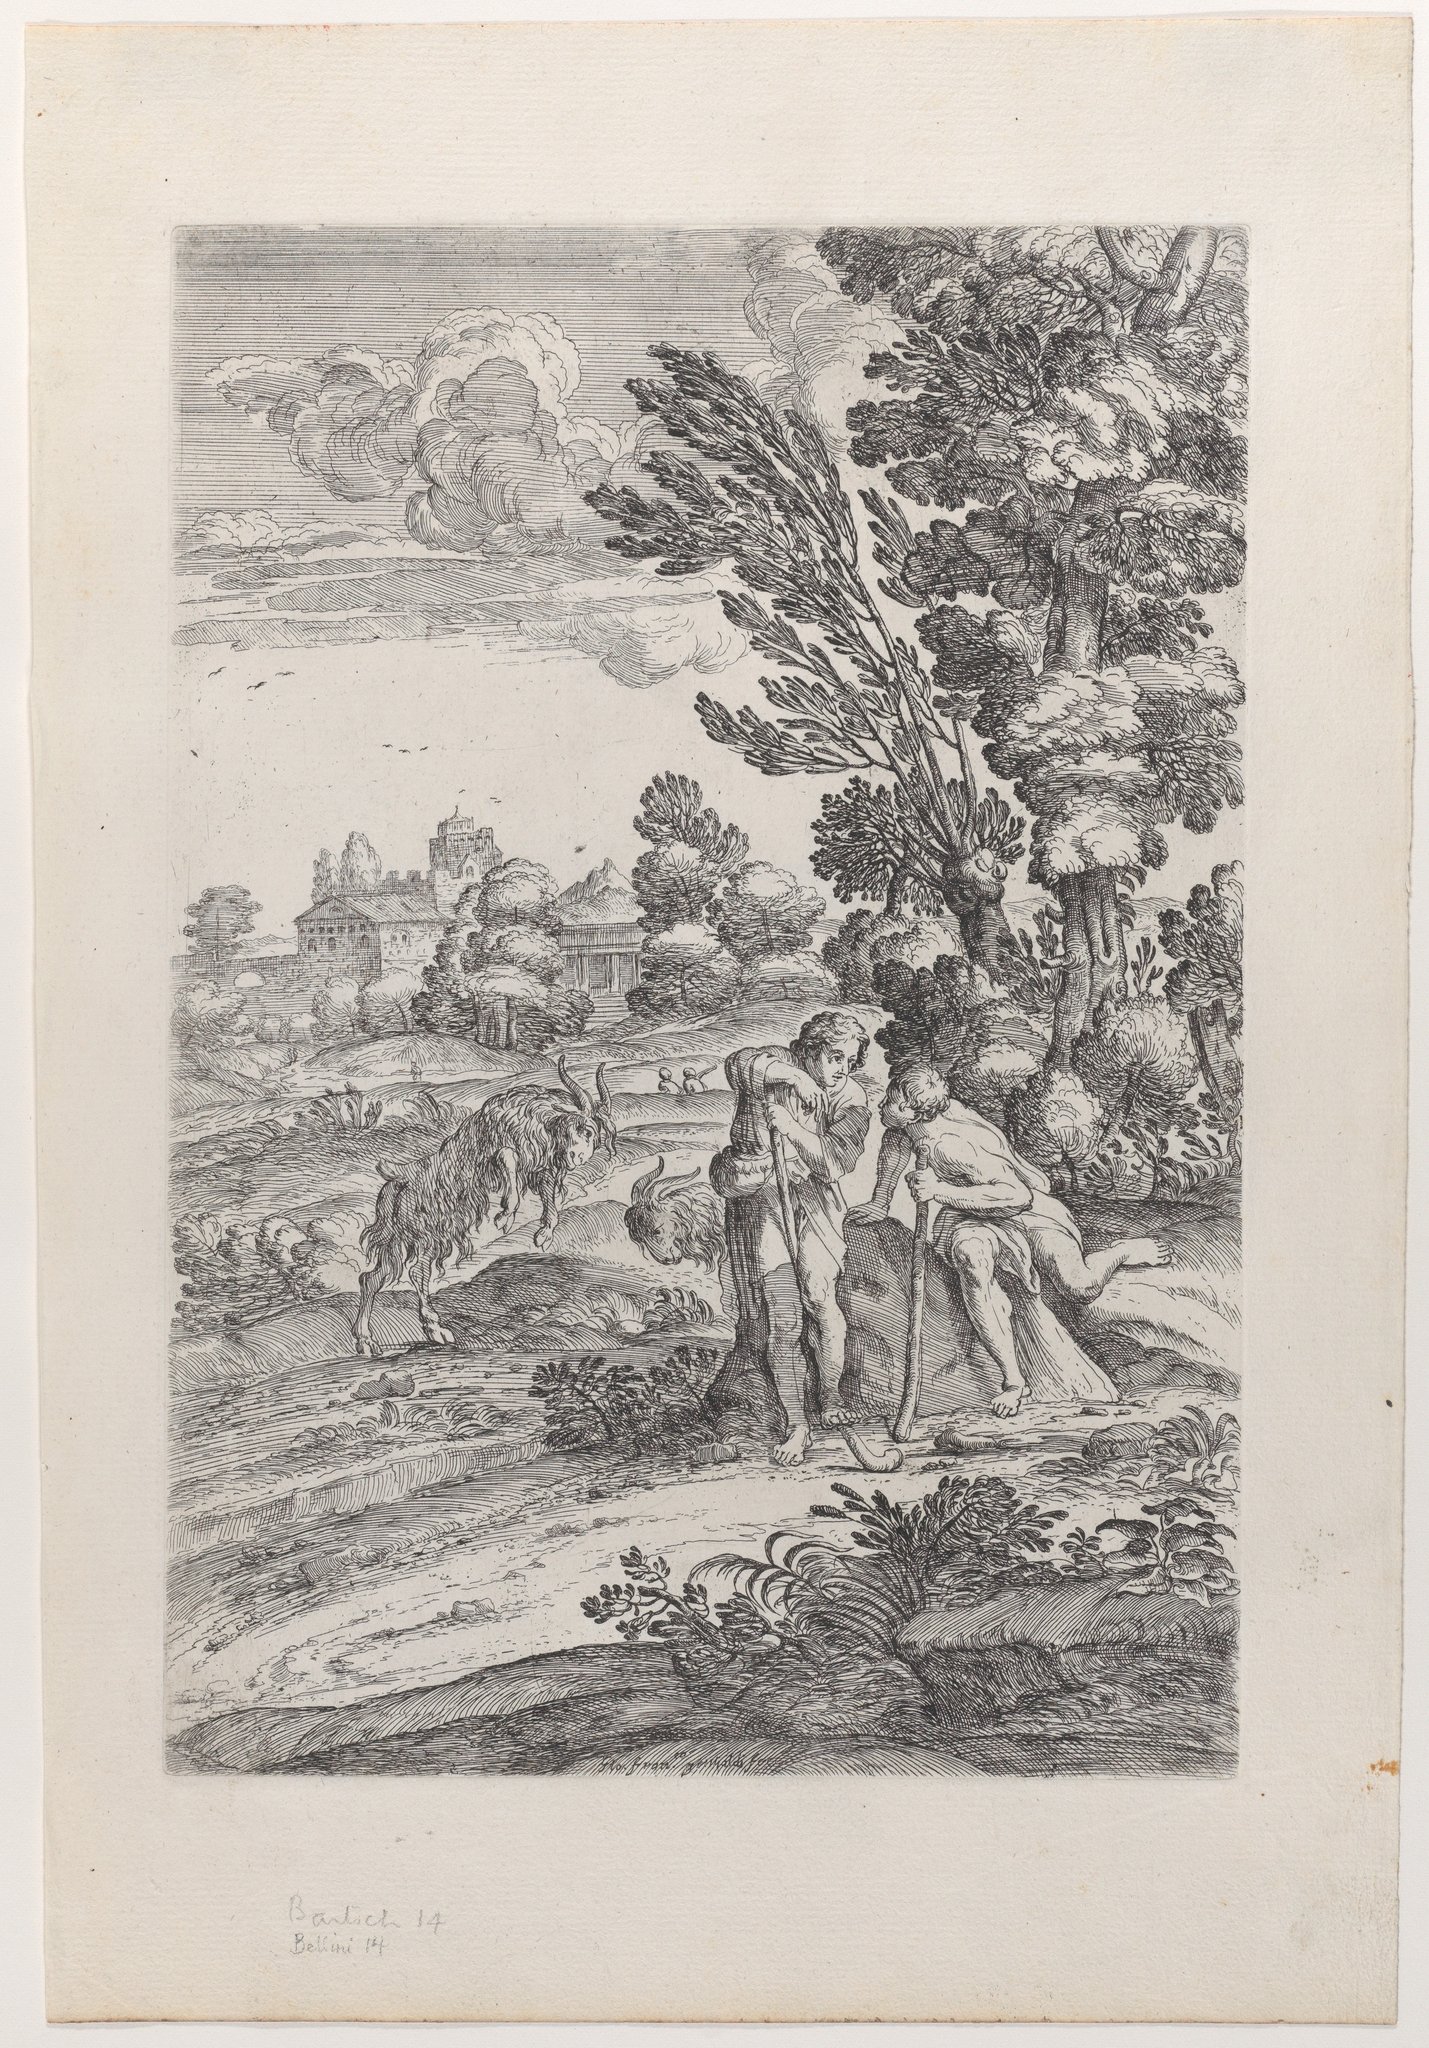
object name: print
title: Landscape With Two Goatherds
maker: giovanni francesco grimaldi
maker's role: artist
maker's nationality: italian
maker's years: 1606-1680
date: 1626-1680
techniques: etching